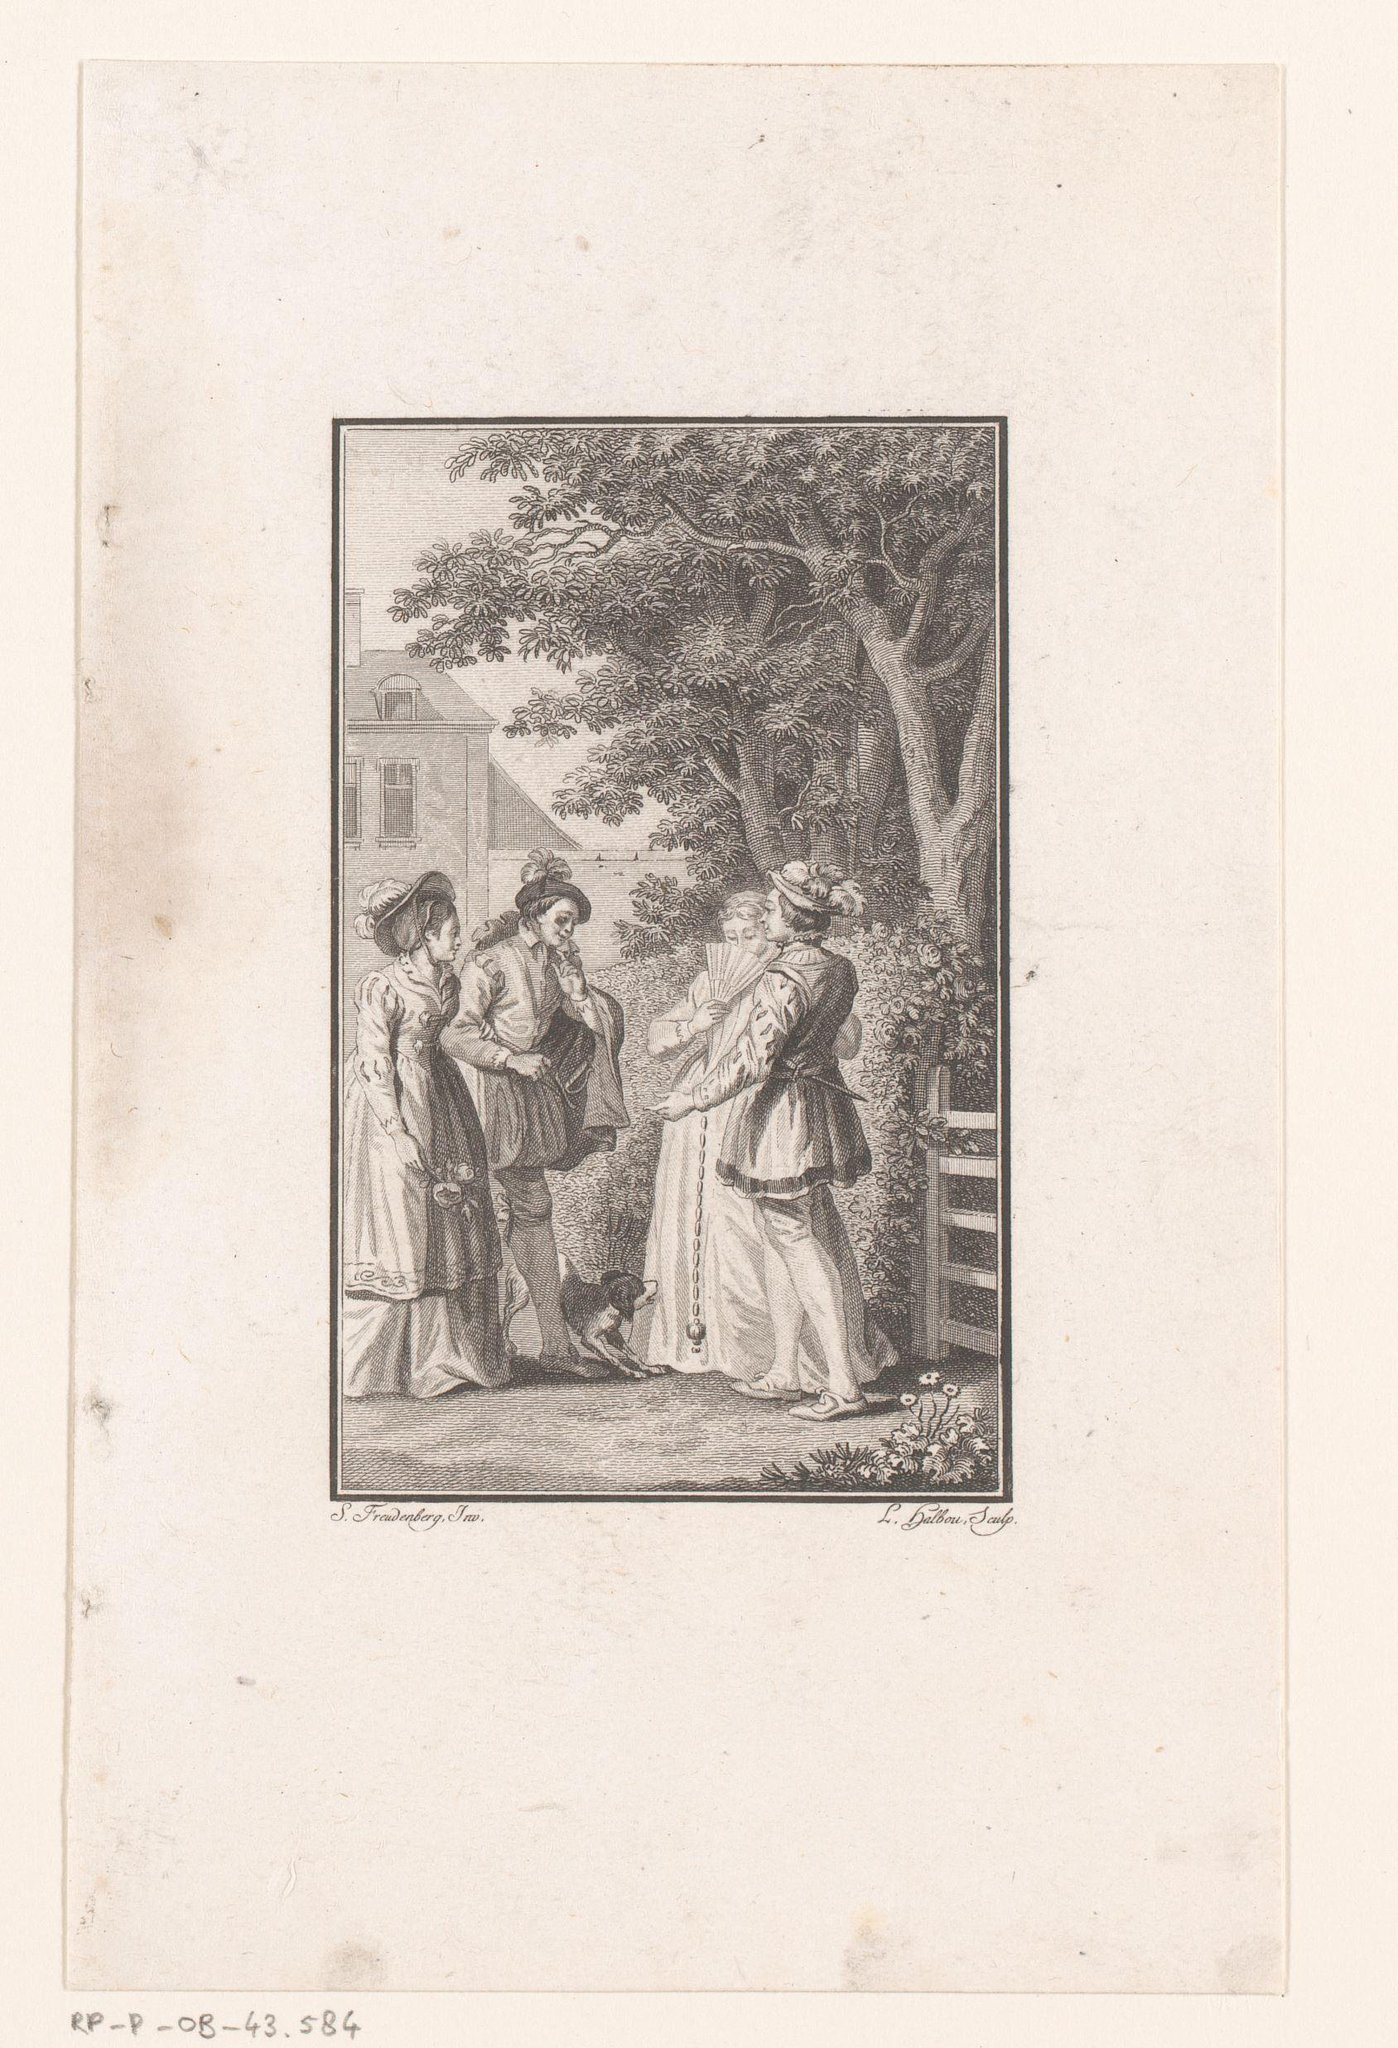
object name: book illustration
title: Twee elegante paren ontmoeten elkaar in een tuin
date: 1781-1782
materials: paper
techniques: etching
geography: bern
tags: courting, couple of lovers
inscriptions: collector's mark: Lugt 2228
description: Prent uit: Les Nouvelles de Marguerite, reine de Navarre. Bern: la nouvelle Société Typographique, 1780-1781.